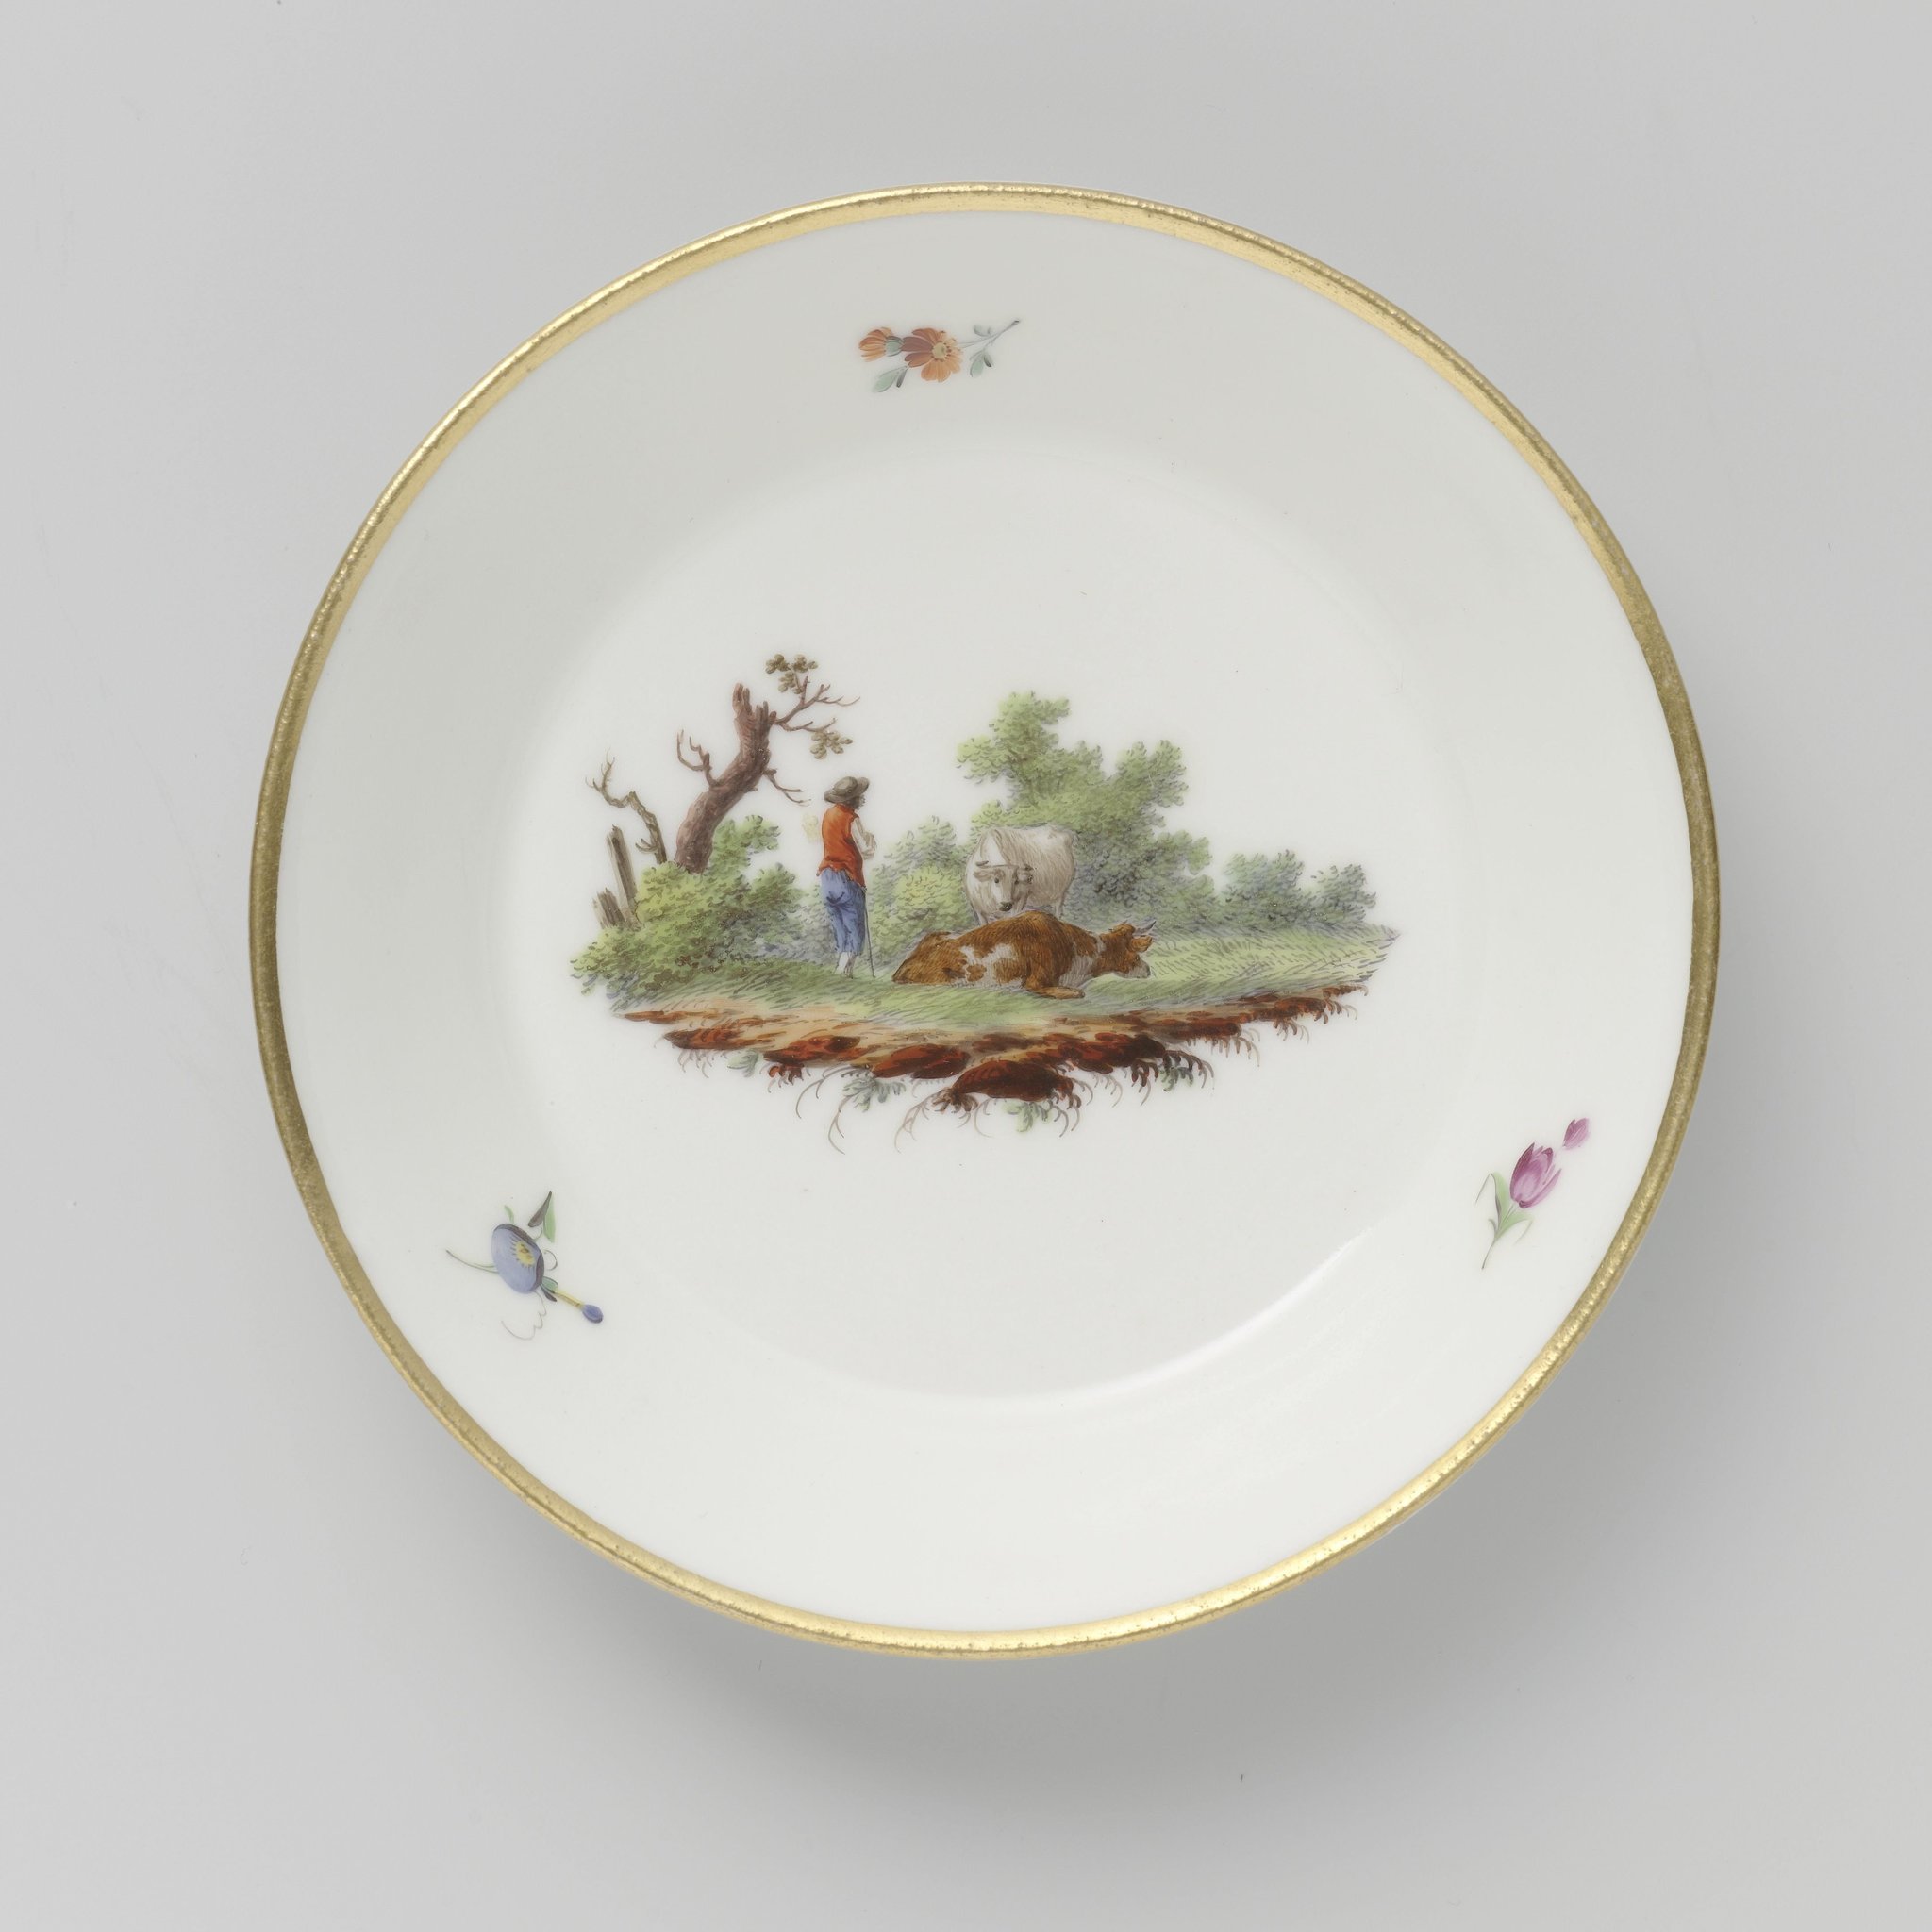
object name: tea service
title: Schotel, beschilderd met een landschap met vee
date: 1809-1814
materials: porcelain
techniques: painted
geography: nieuwer-amstel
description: Schotel, beschilderd met landschap met vee. Gemerkt: Amstel in blauw.